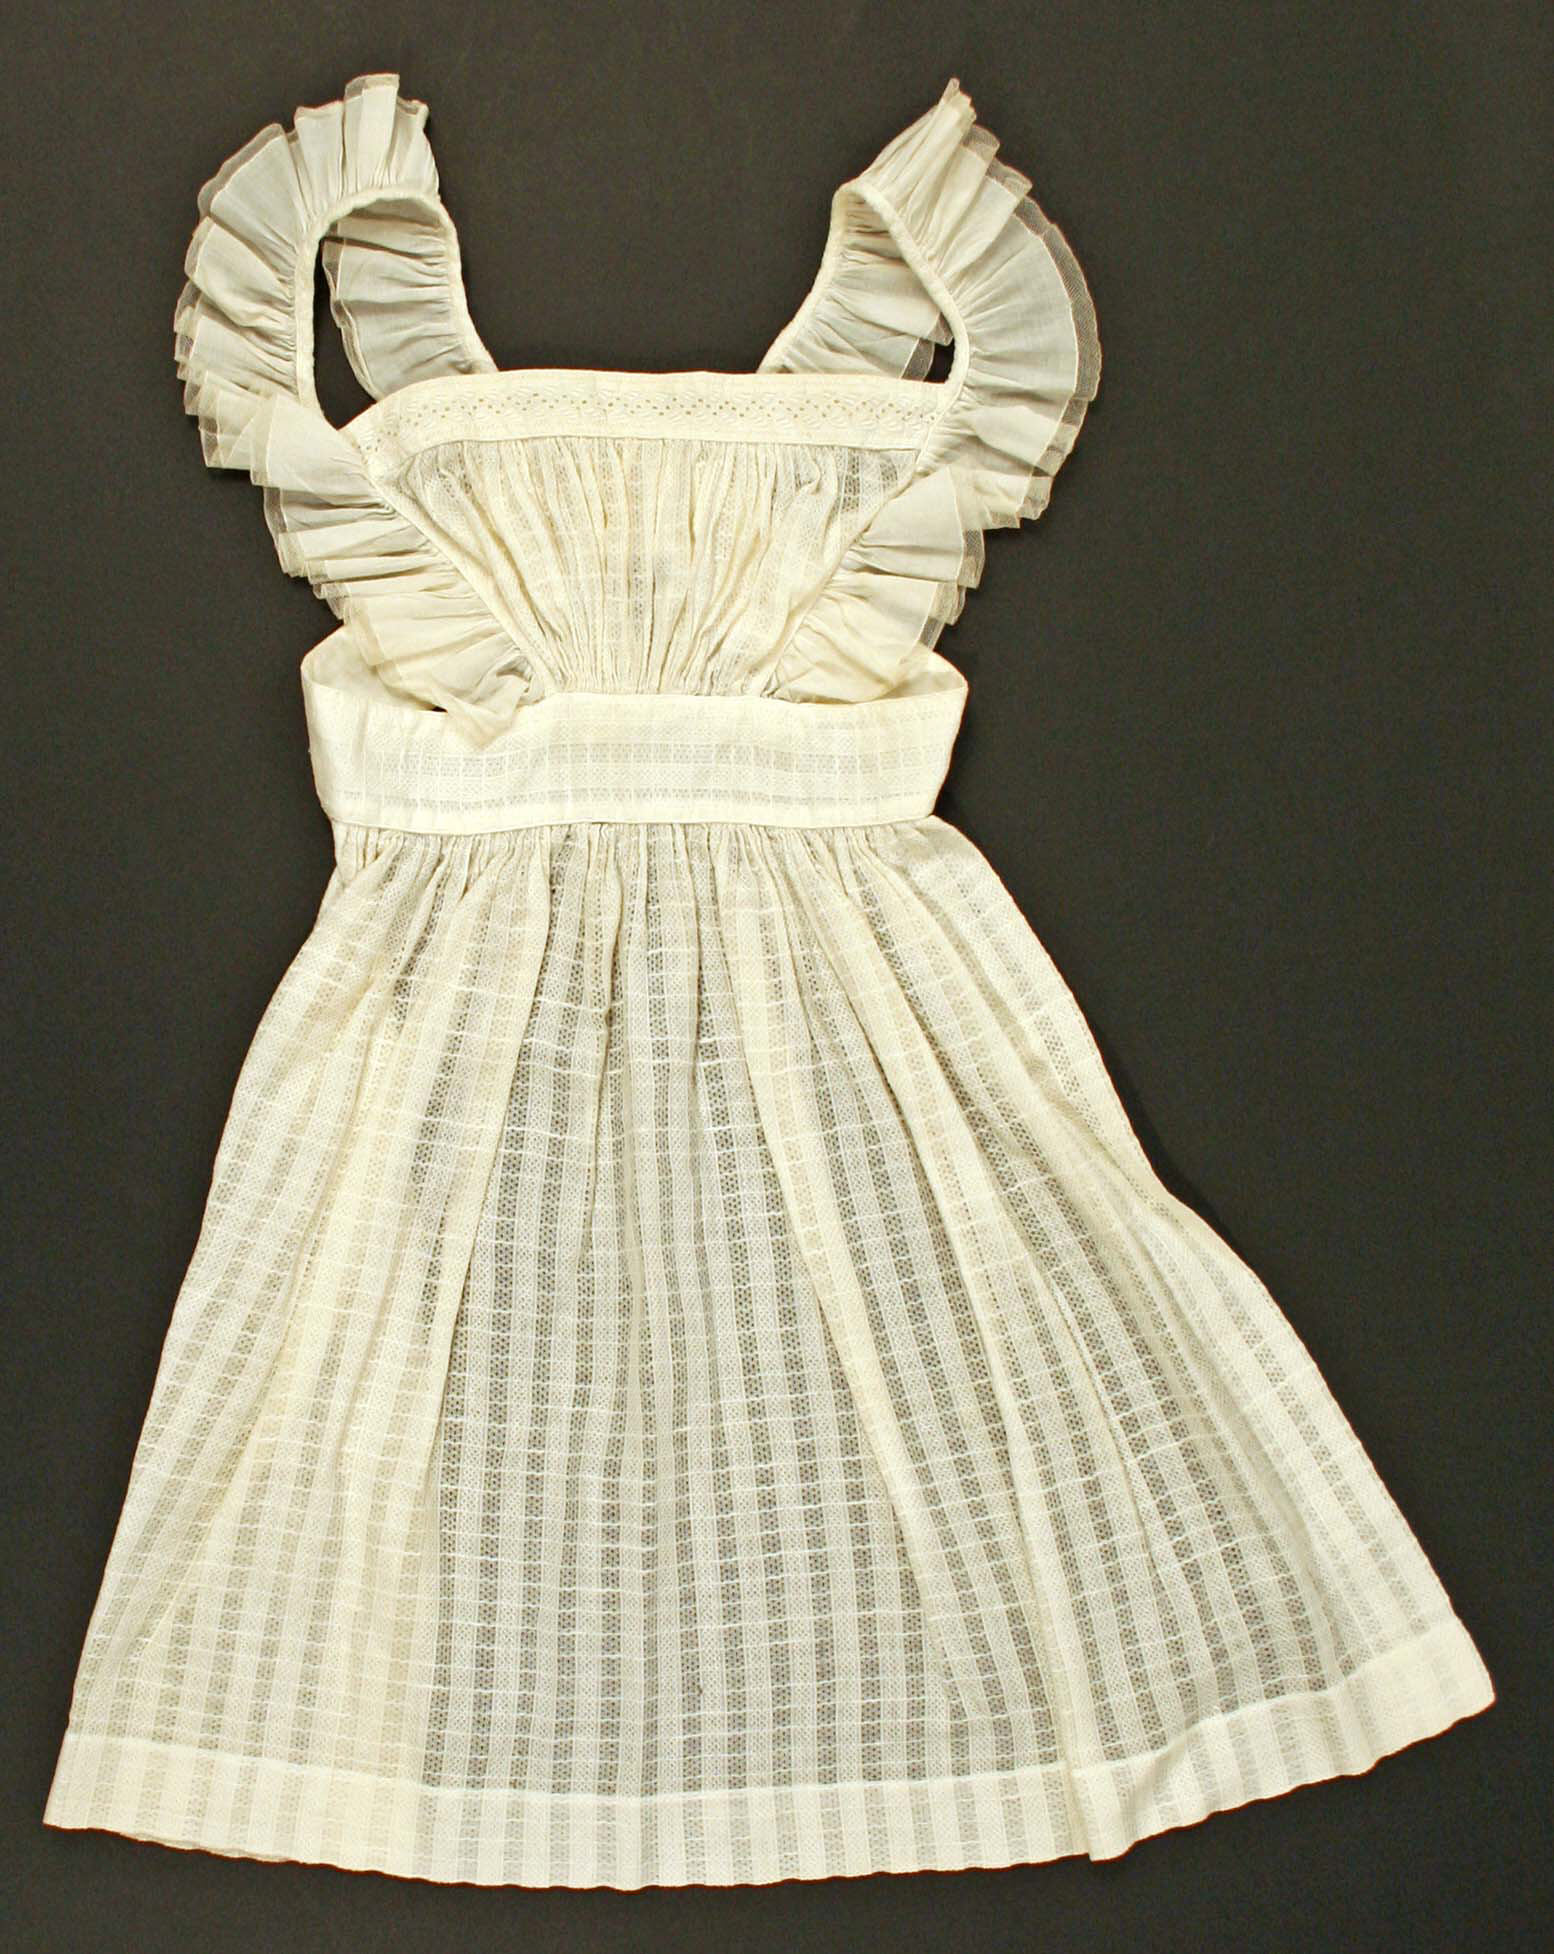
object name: accessory set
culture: american or european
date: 1830-1839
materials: cotton